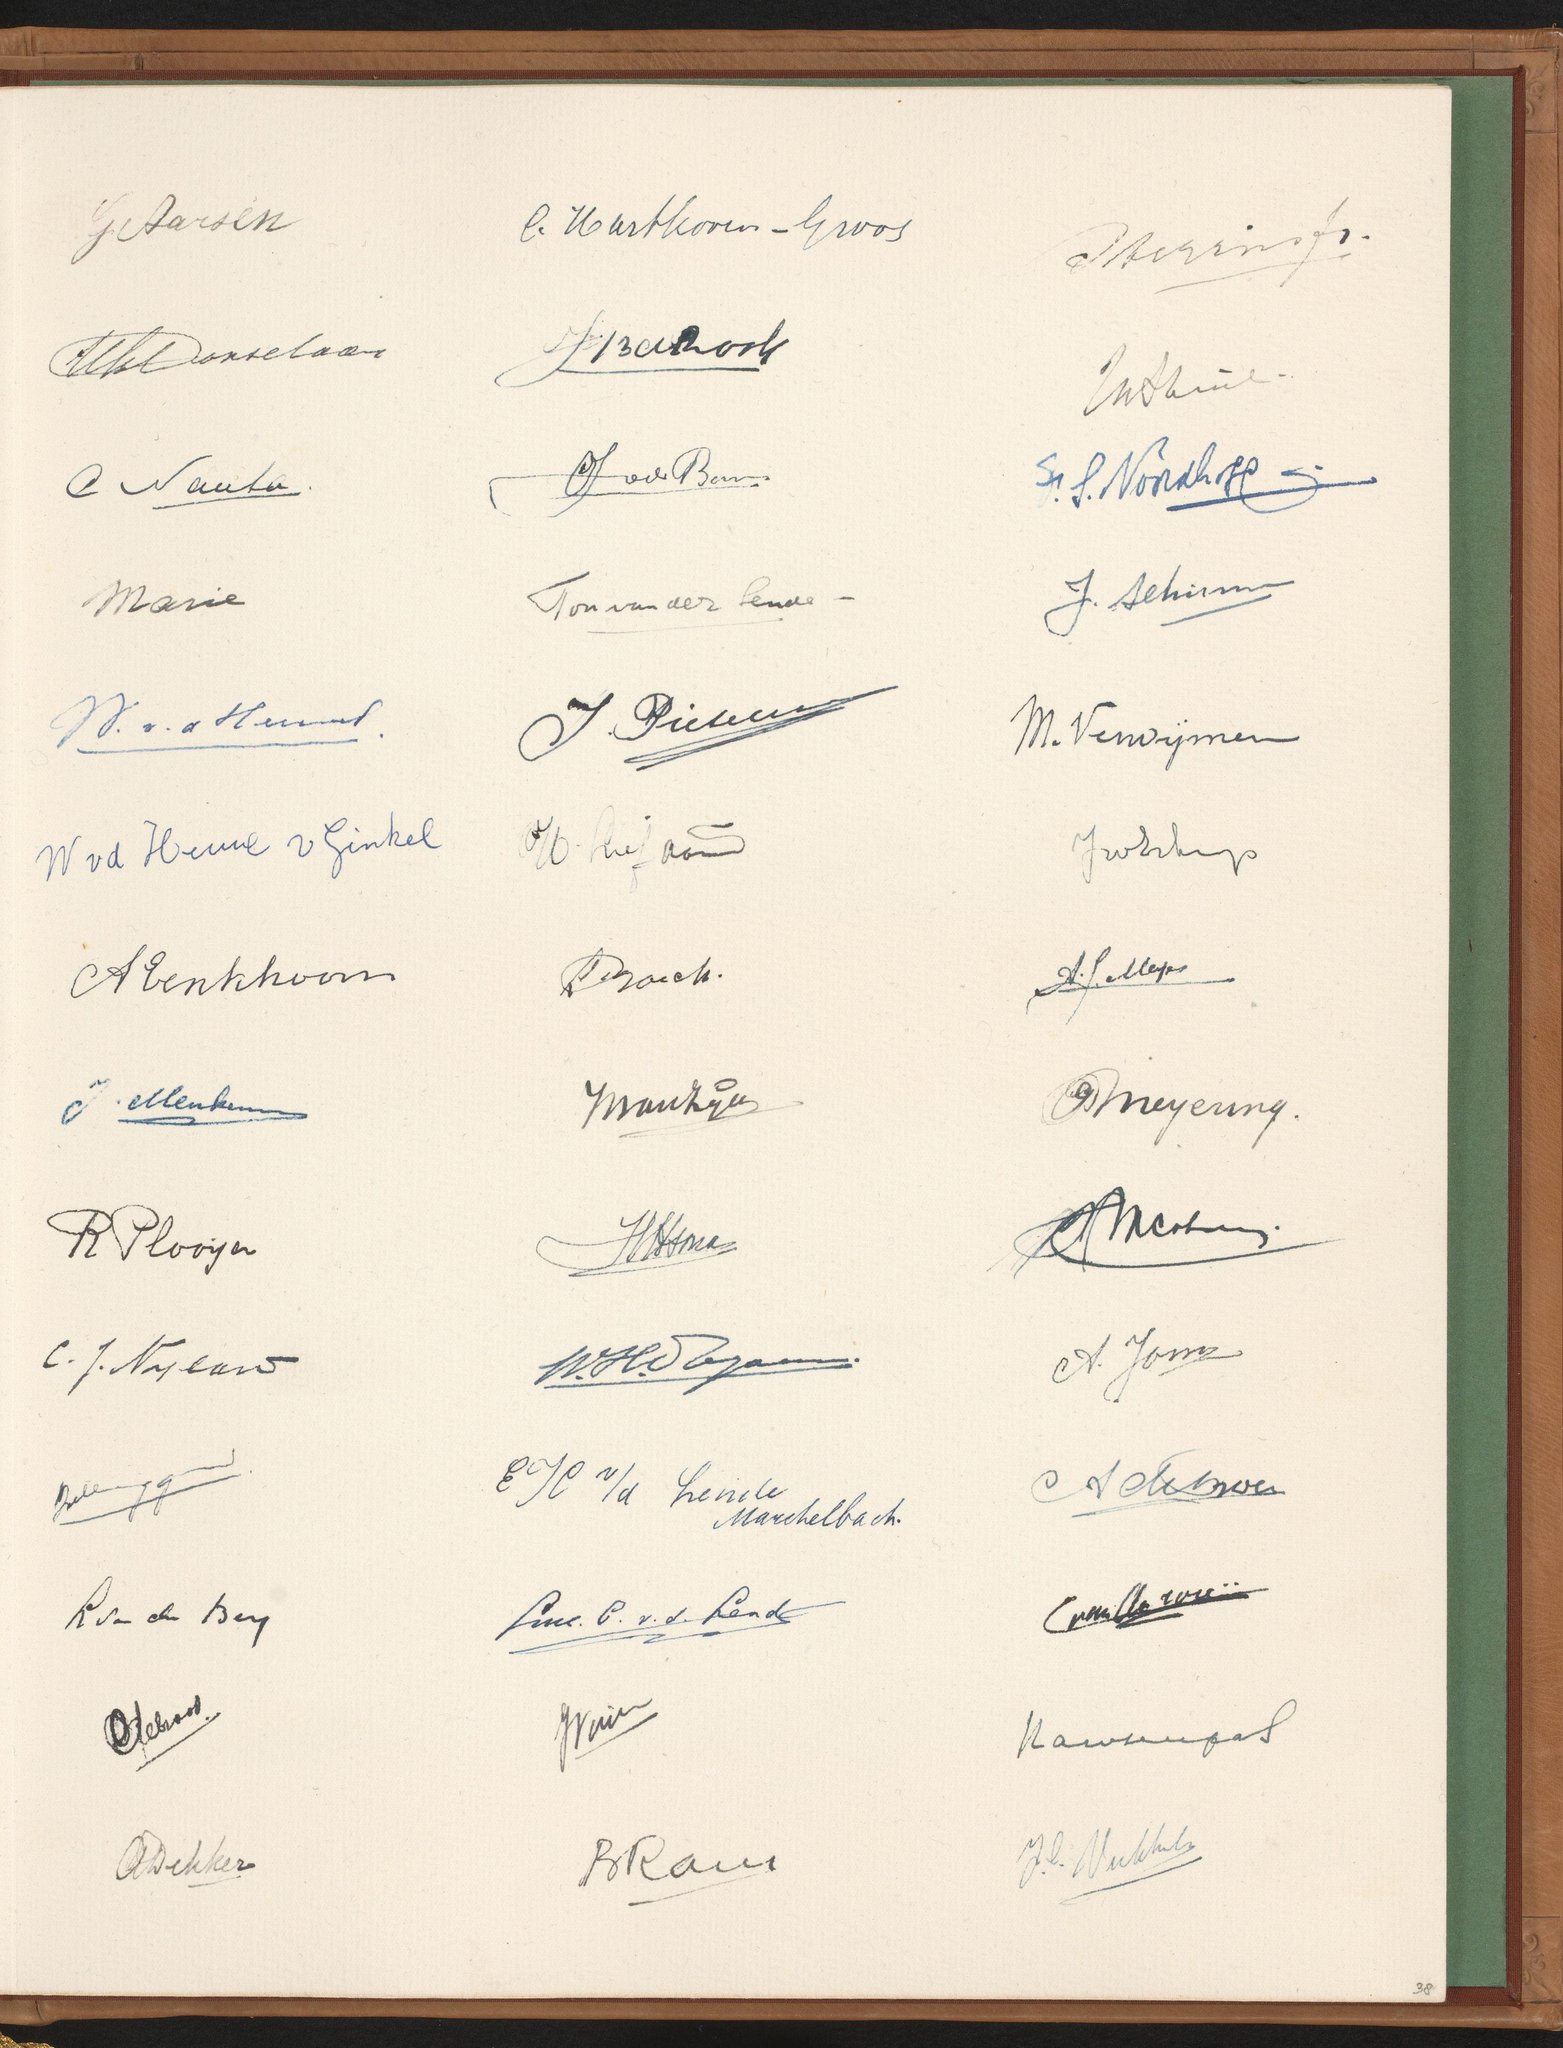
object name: text sheet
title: Blad met handtekeningen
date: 1949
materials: ink, paper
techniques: handwriting, pen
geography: netherlands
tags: modern professional organization, trade union, reception, cocktail party, handwriting, written text, amsterdam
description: Blad met handtekeningen van aanwezigen op het afscheidsfeest. Onderdeel van het fotoalbum ter gelegenheid van het afscheid van Evert Kupers als voorzitter van de NVV op 14 juli 1949 in Amsterdam.